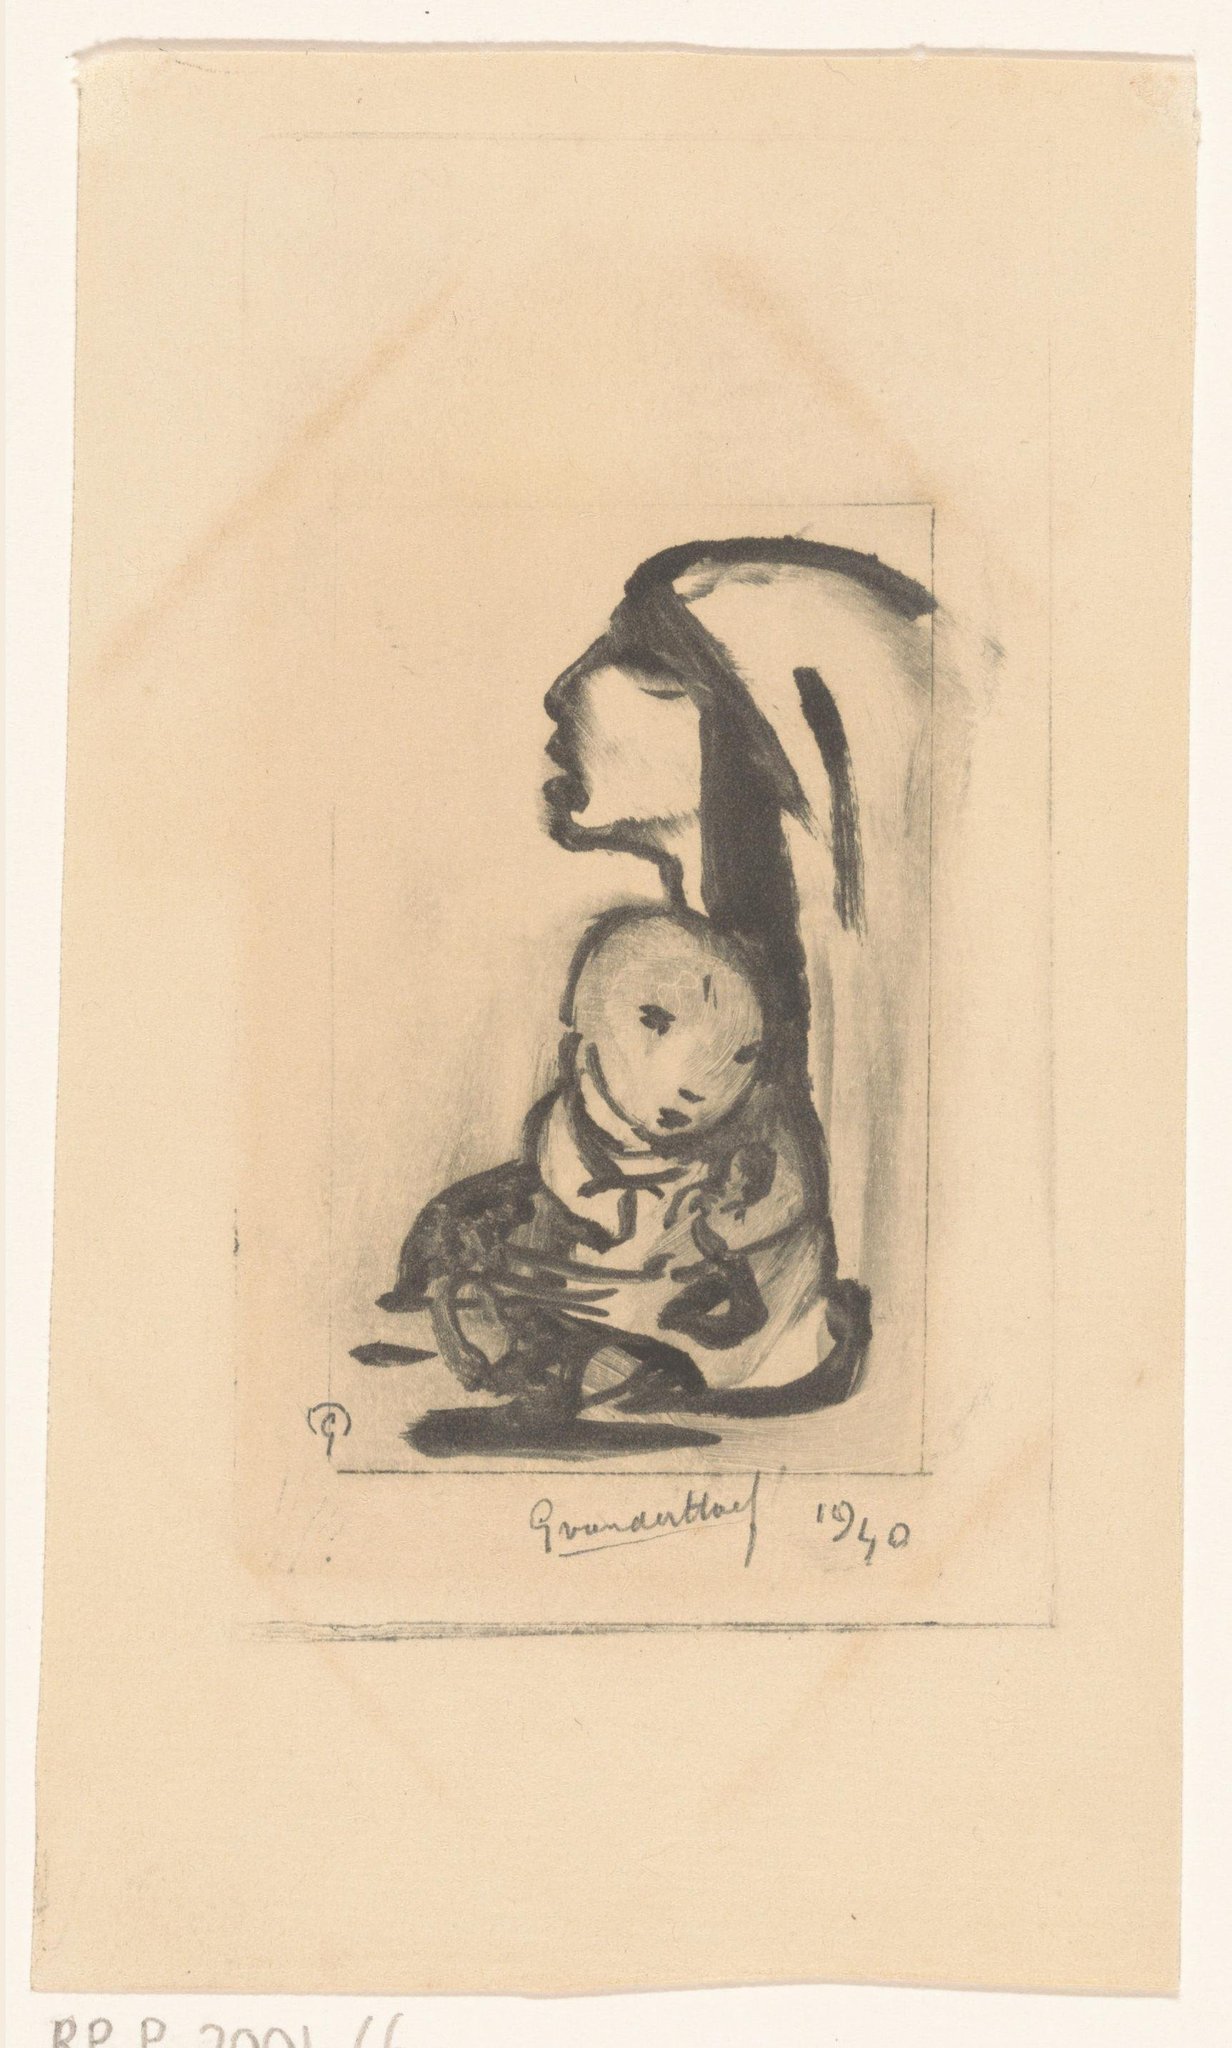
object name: print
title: Vrouw met kind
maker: gerrit van der hoef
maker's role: print maker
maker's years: 1879-1954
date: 1940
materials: paper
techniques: monotype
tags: mother and baby or young child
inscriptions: collector's mark: Lugt 2228, collector's mark: Lugt 2760